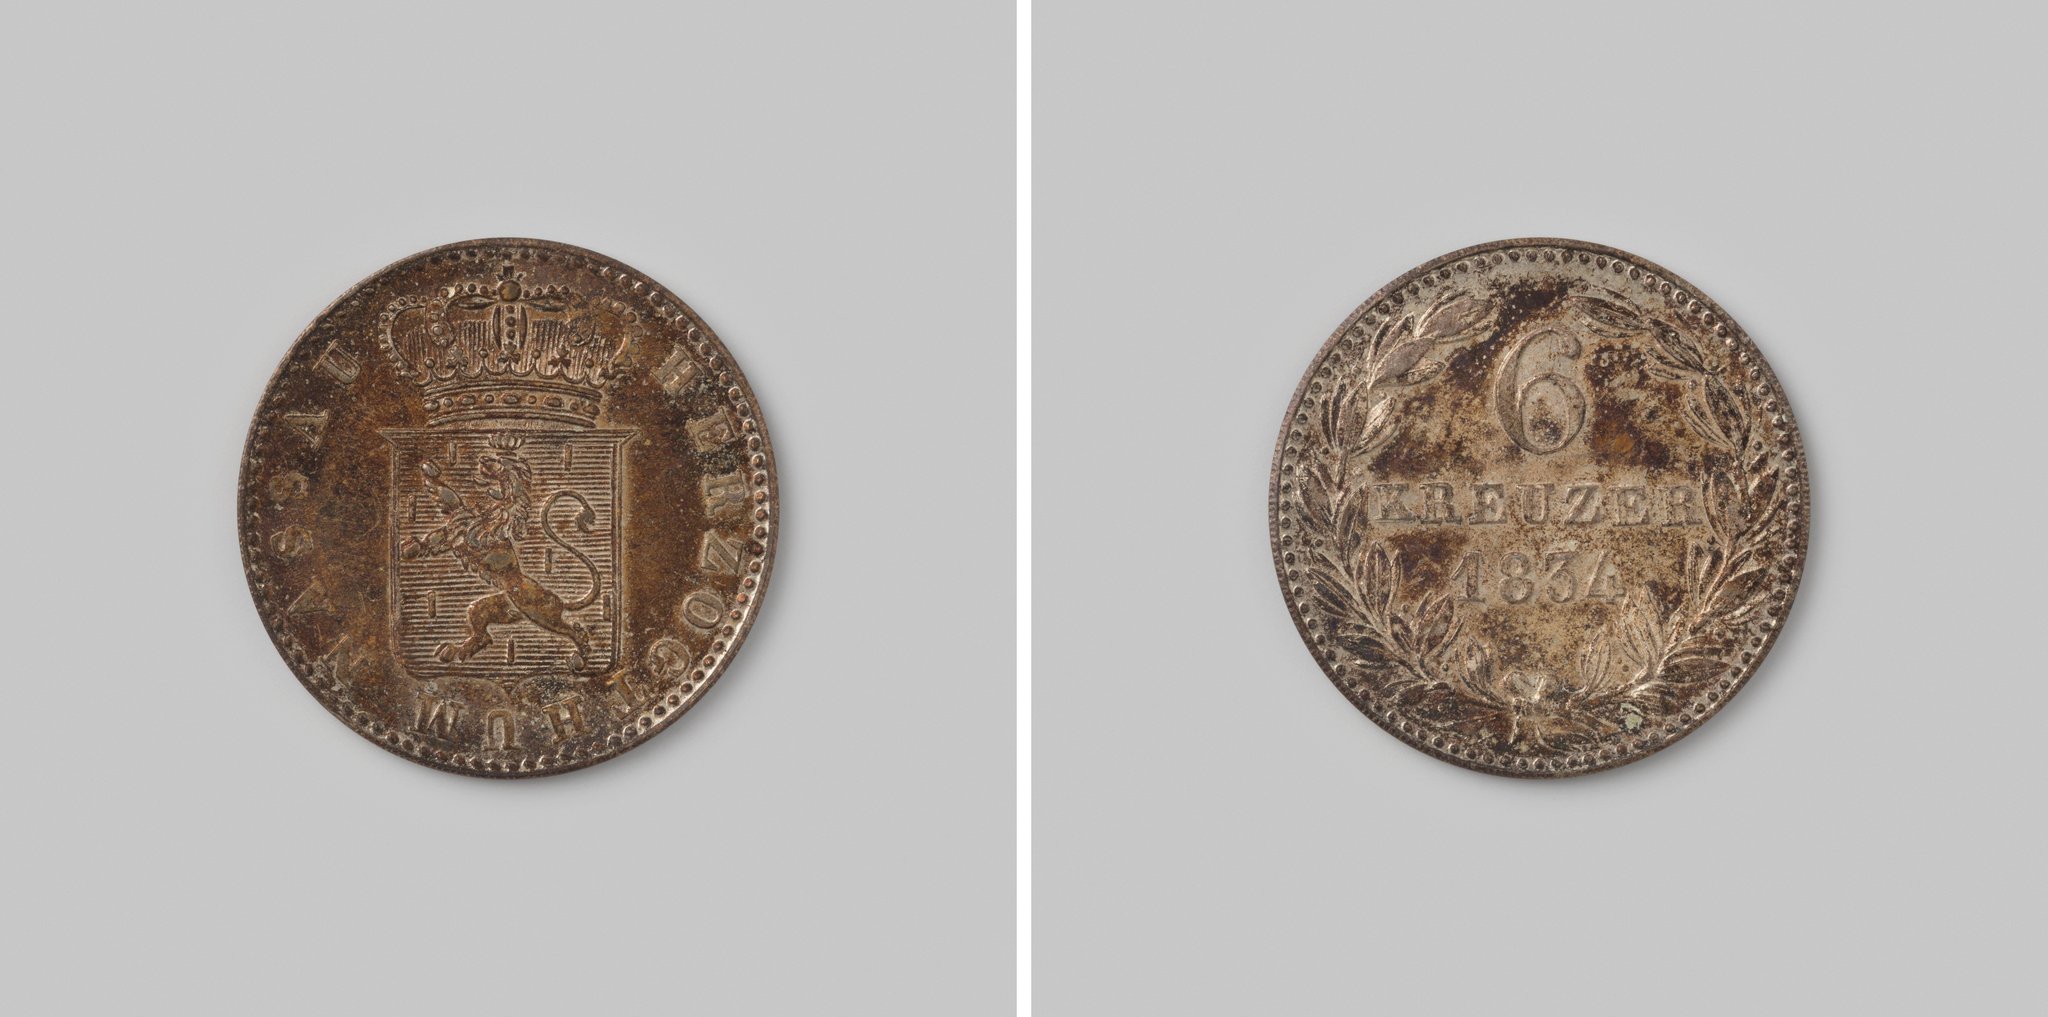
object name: coin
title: Hertogdom Nassau, Wilhelm, 6 Kreuzer, 1834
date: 1834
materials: silver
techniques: striking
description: Zilveren munt. Voorzijde: gekroond wapenschild van Nassau. Keerzijde: binnen twee samengebonden lauriertakken waarde-aanduiding in twee regels, waaronder jaartal. Kartelrand.